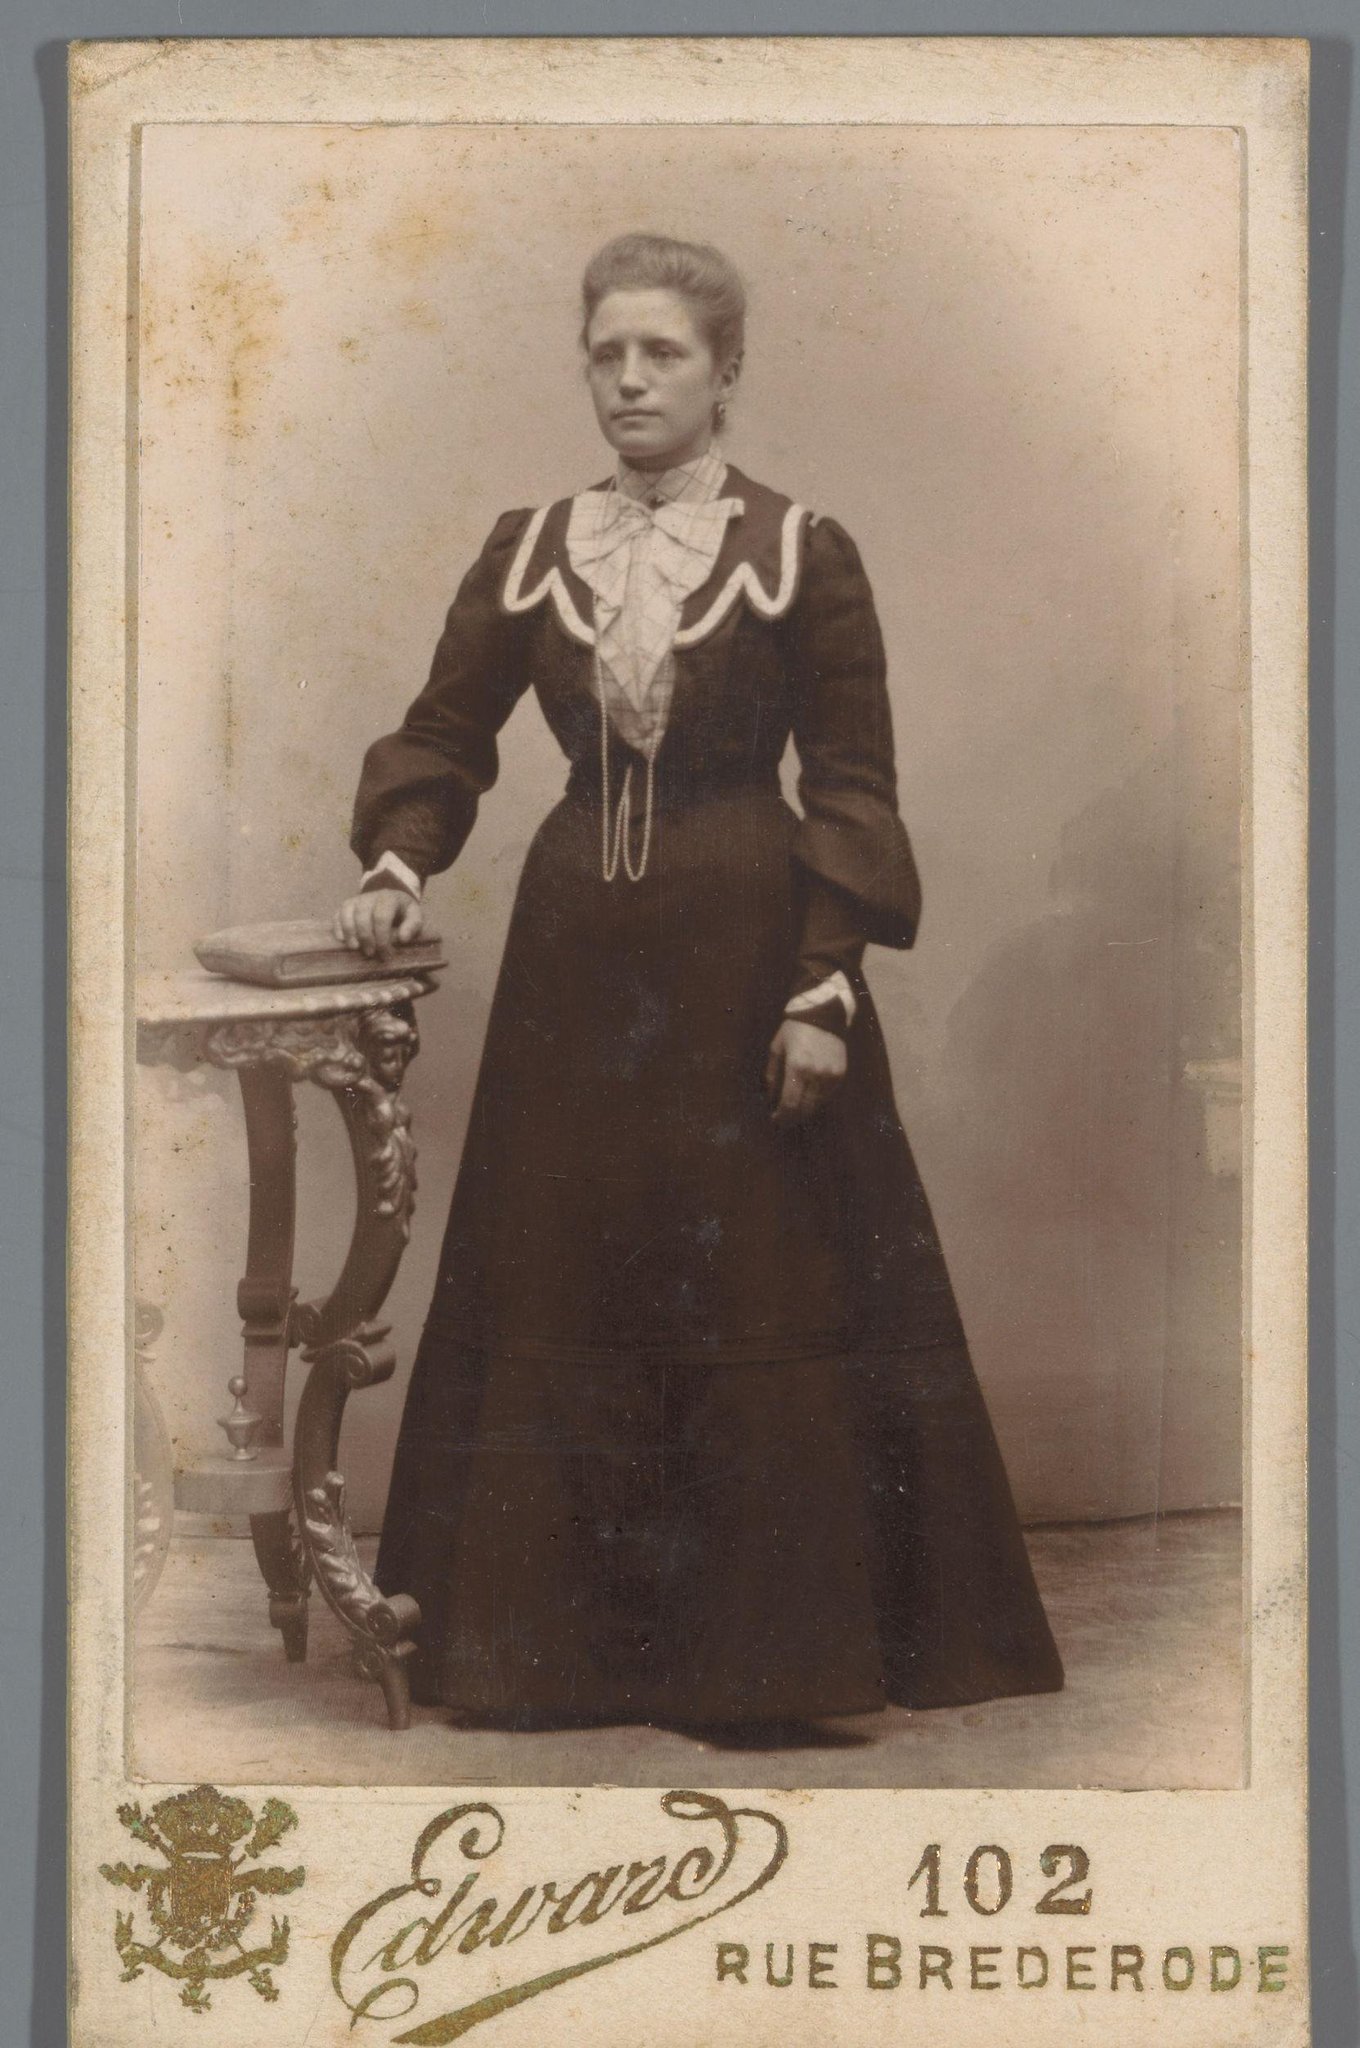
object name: semi enamel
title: Portret van mevrouw Rerberg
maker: edward van boghout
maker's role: fotograaf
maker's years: 1855-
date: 1901-1908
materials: paper, cardboard, celluloid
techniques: collodion silver print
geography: antwerp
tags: adult woman, historical persons, antwerp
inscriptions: inscription: ‘Photographie/ Artistique/ Edward/ 102/ Rue Brederode/ Anvers/ Atelier de Pose/ au Jardin/ Agrandissements/ en tous genres/ Les clichés sont conservés/ De plaaten worden bewaard.’, inscription: ‘Mme Rerberg Rue de/ Rue de Bruxelles/ Bruxelles 39/ petit buste/ anvers sud’, inscription: ‘Edward/ 102/ Rue Brederode’, number: ‘641’